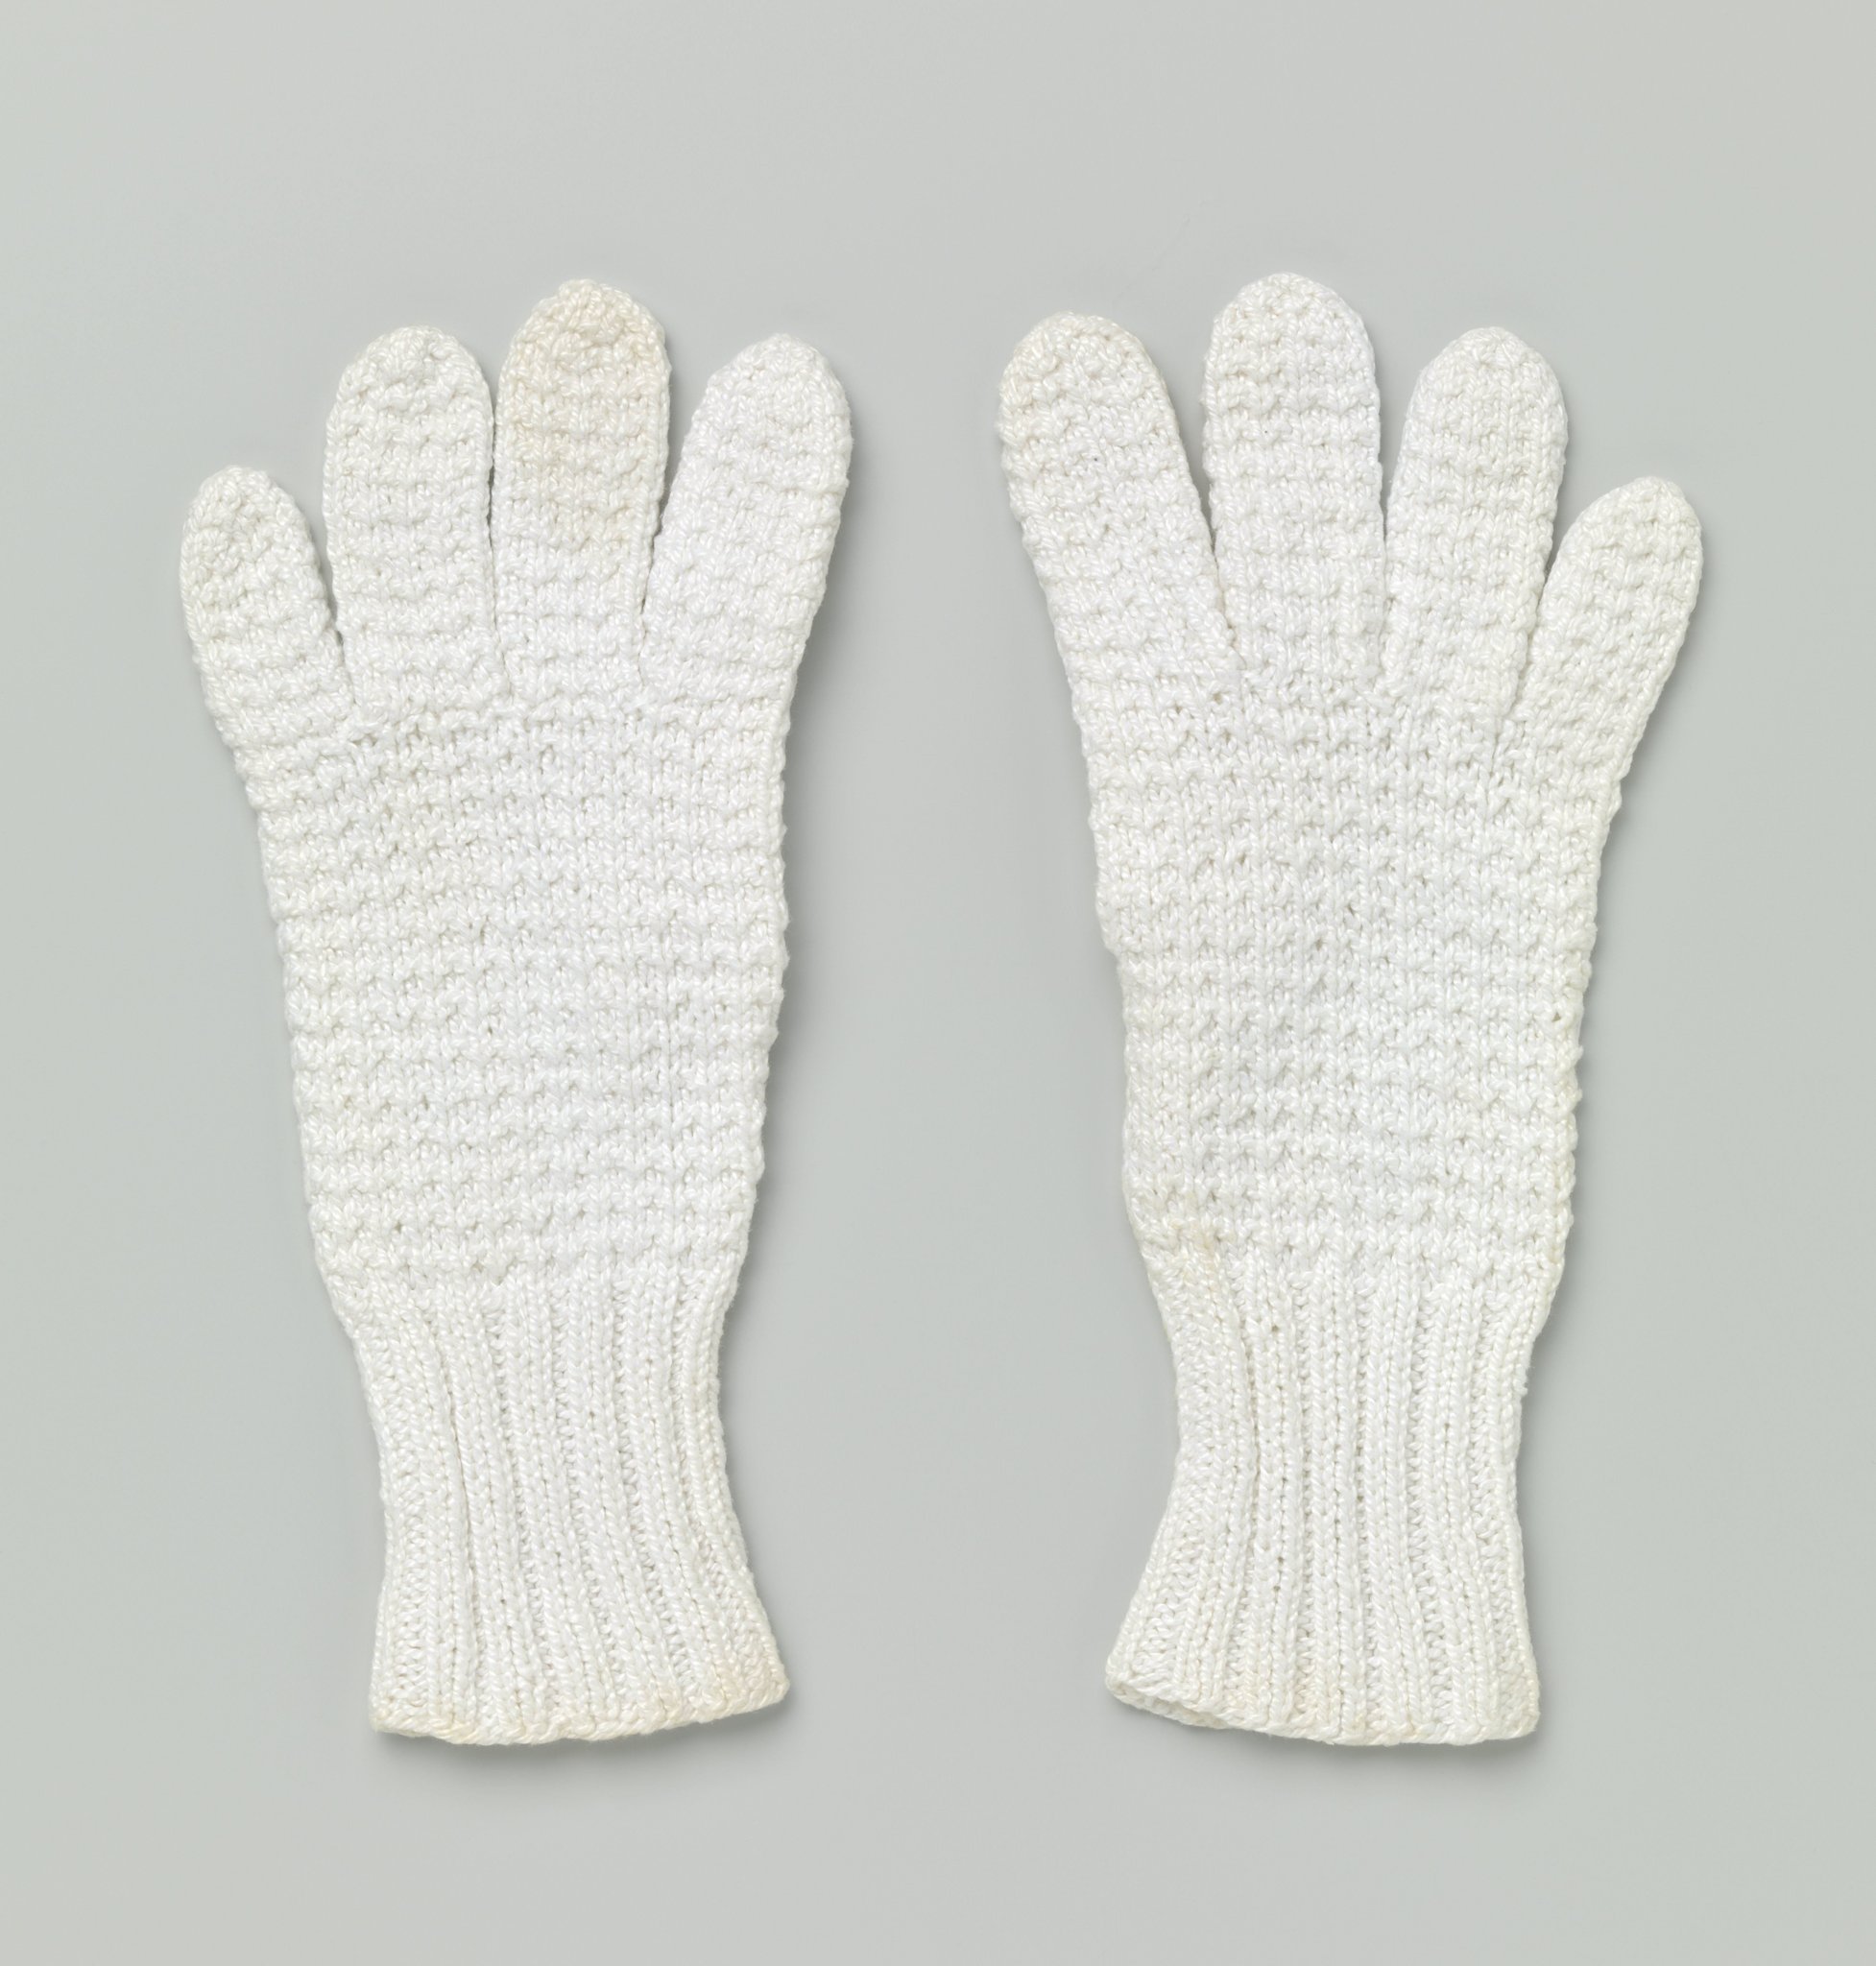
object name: glove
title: Handschoen van een rijkostuum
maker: Anonymous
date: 1934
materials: cotton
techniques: knitting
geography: netherlands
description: Rechterhandschoen van witte katoen en gebreid in gerstekorrelpatroon, behorende bij een rijkostuum .